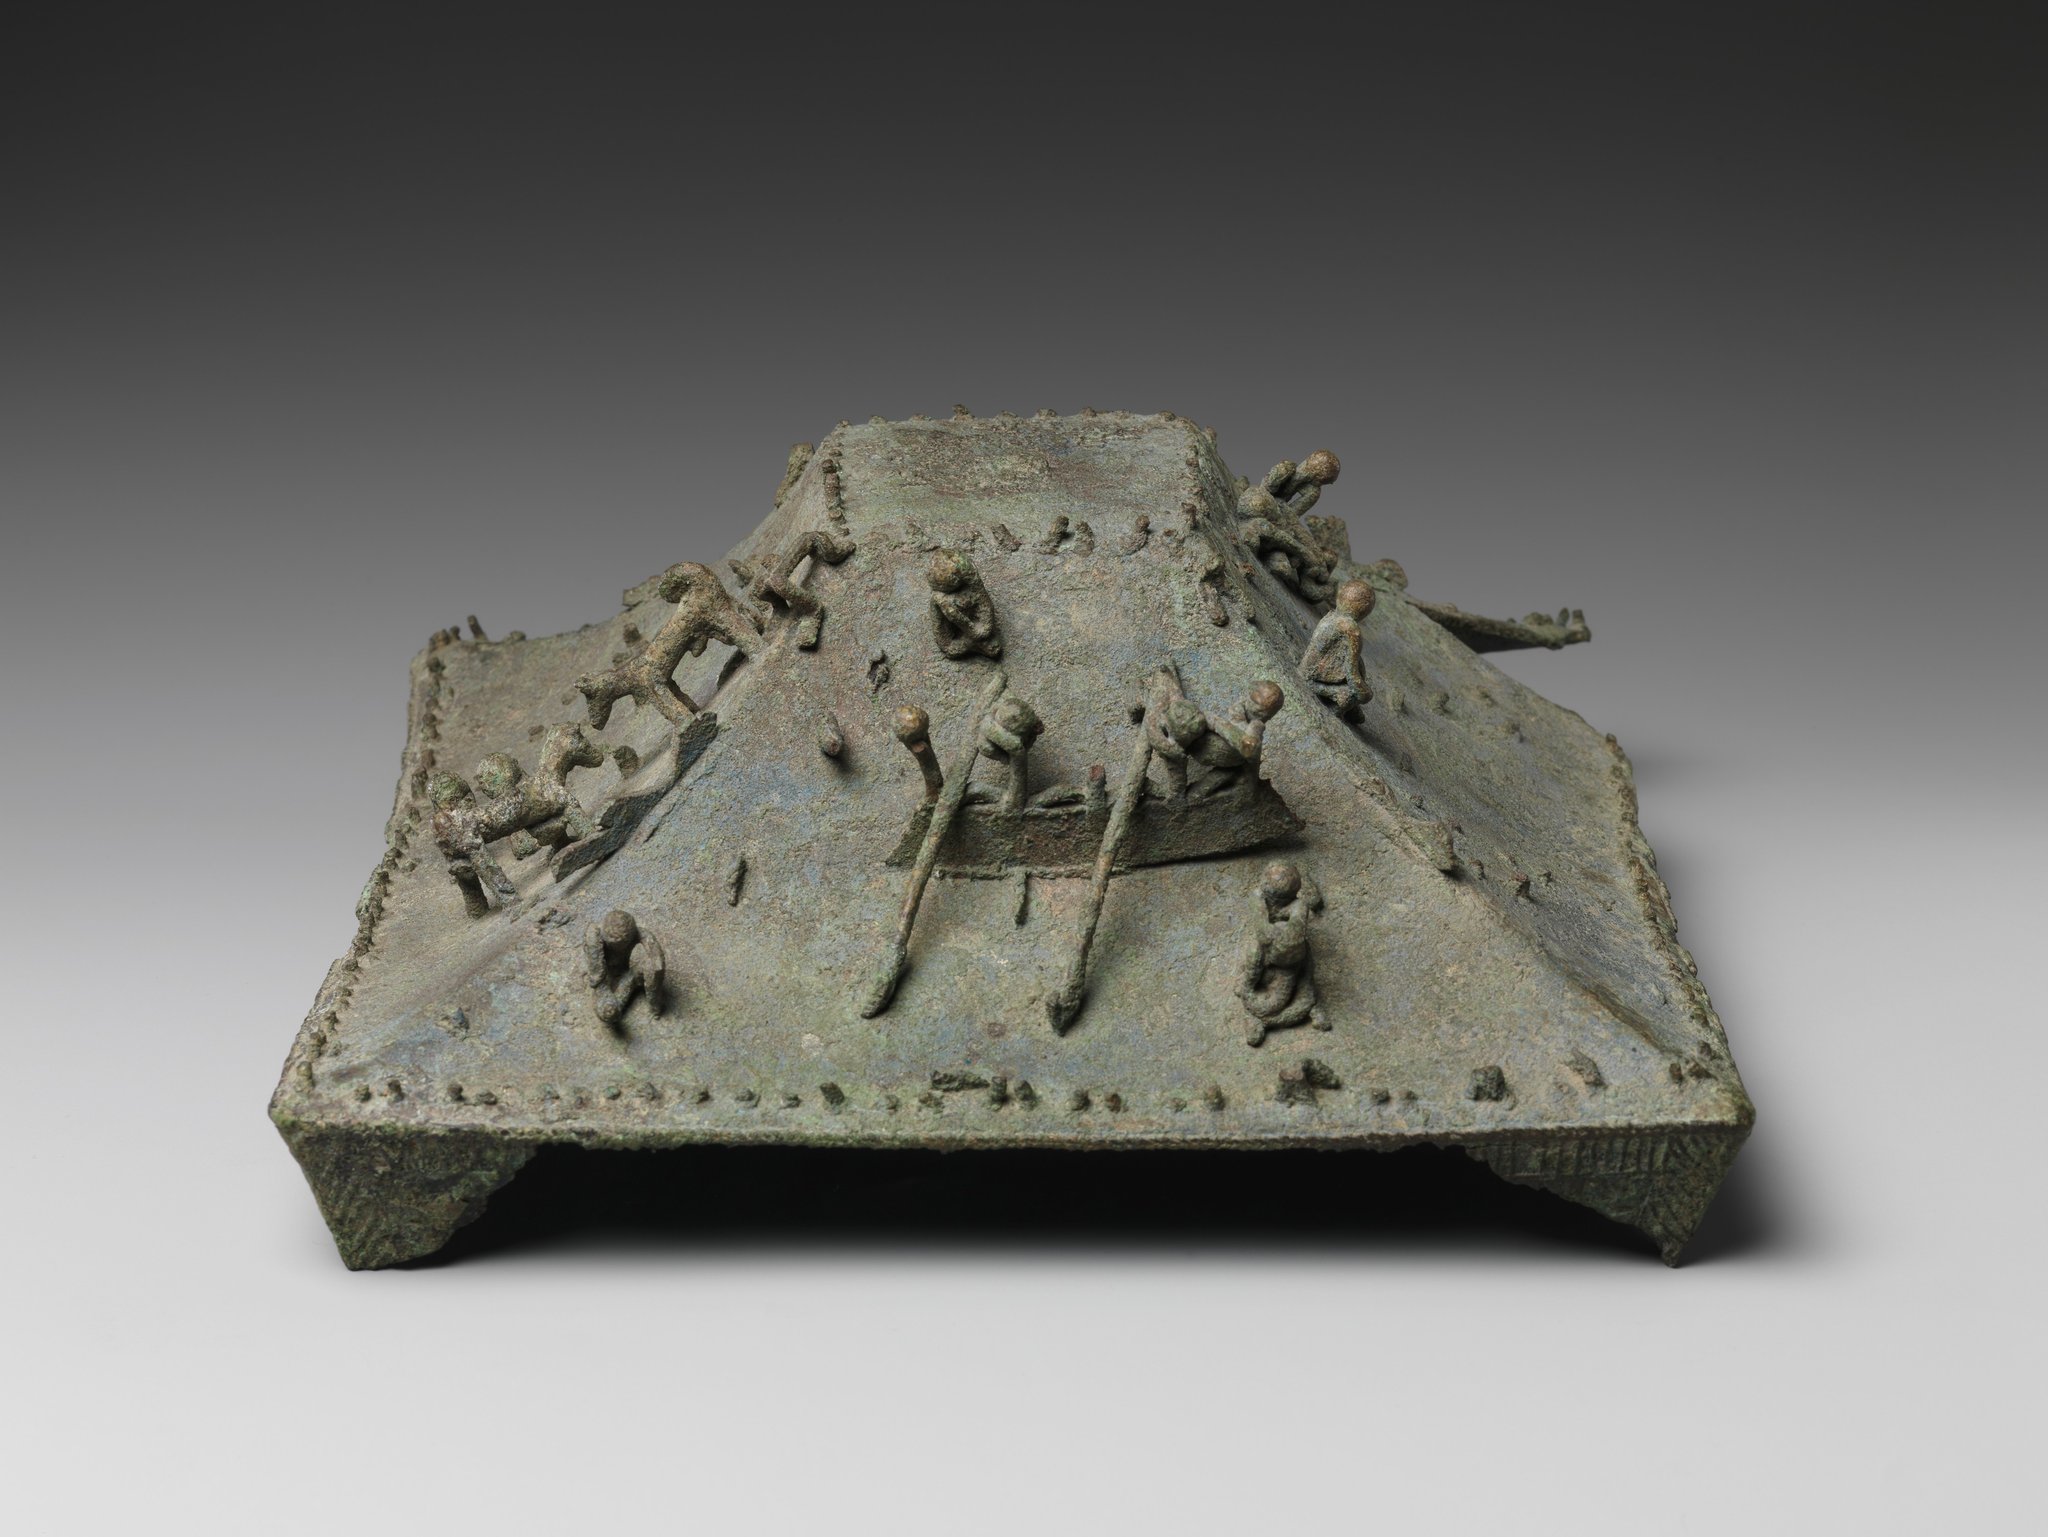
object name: lid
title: Lid with Figurative Scenes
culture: indonesian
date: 1301-1400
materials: bronze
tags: animals,boats